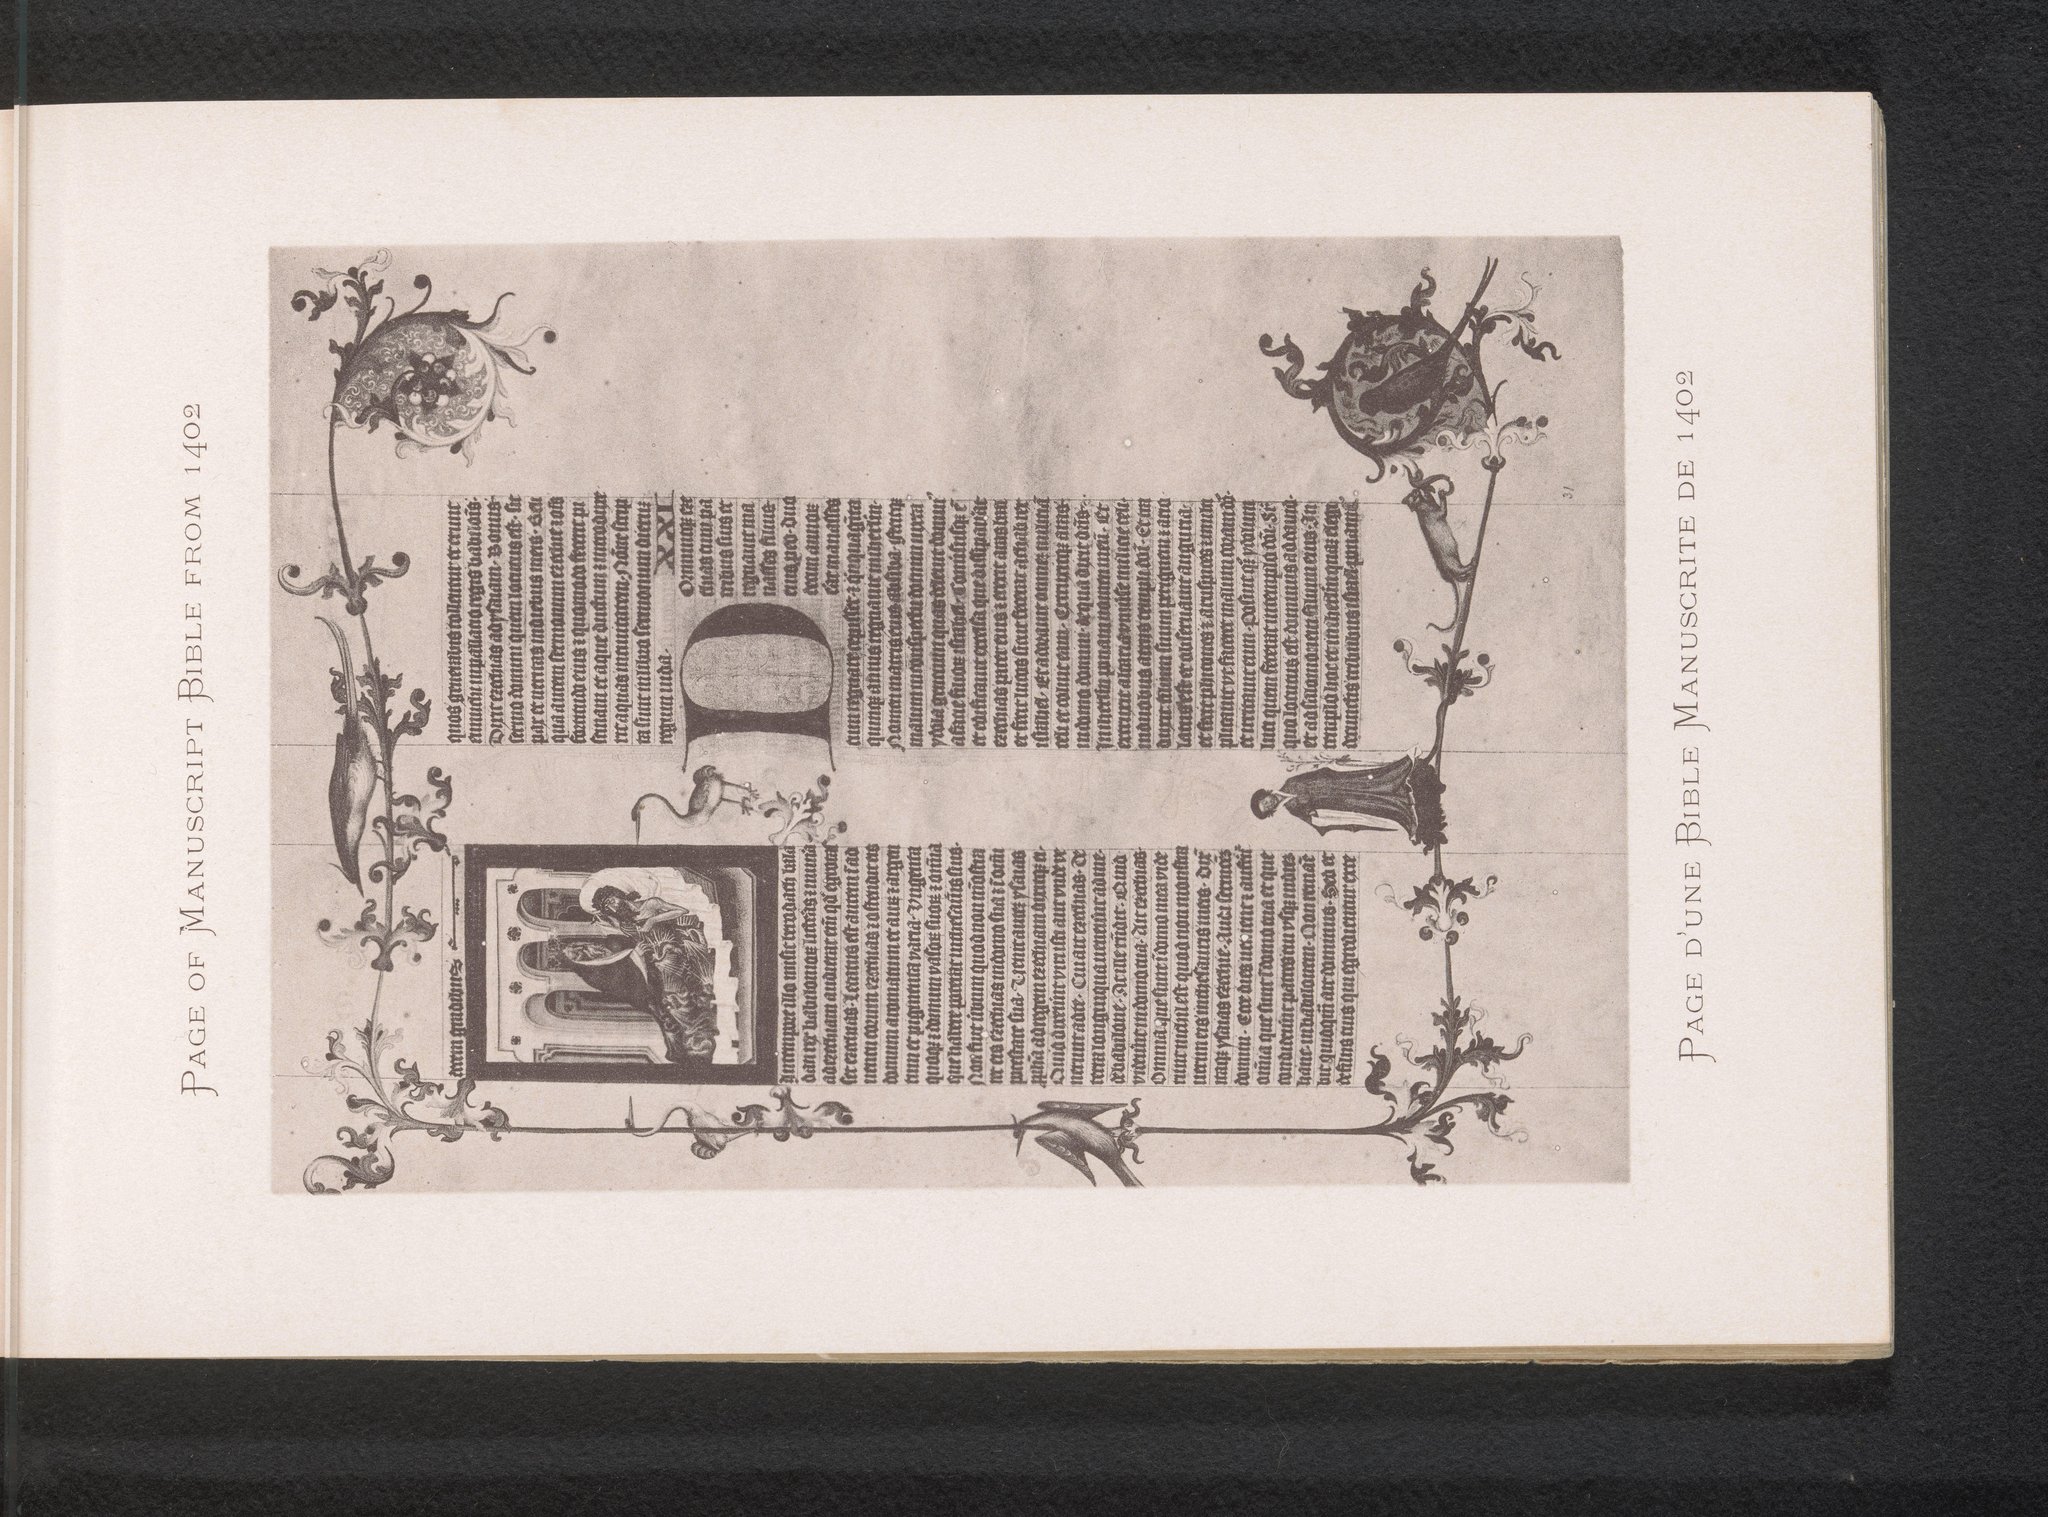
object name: page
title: Page of manuscript bible from 1402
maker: Anonymous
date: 1892-1897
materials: paper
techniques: photograph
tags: handwriting, written text